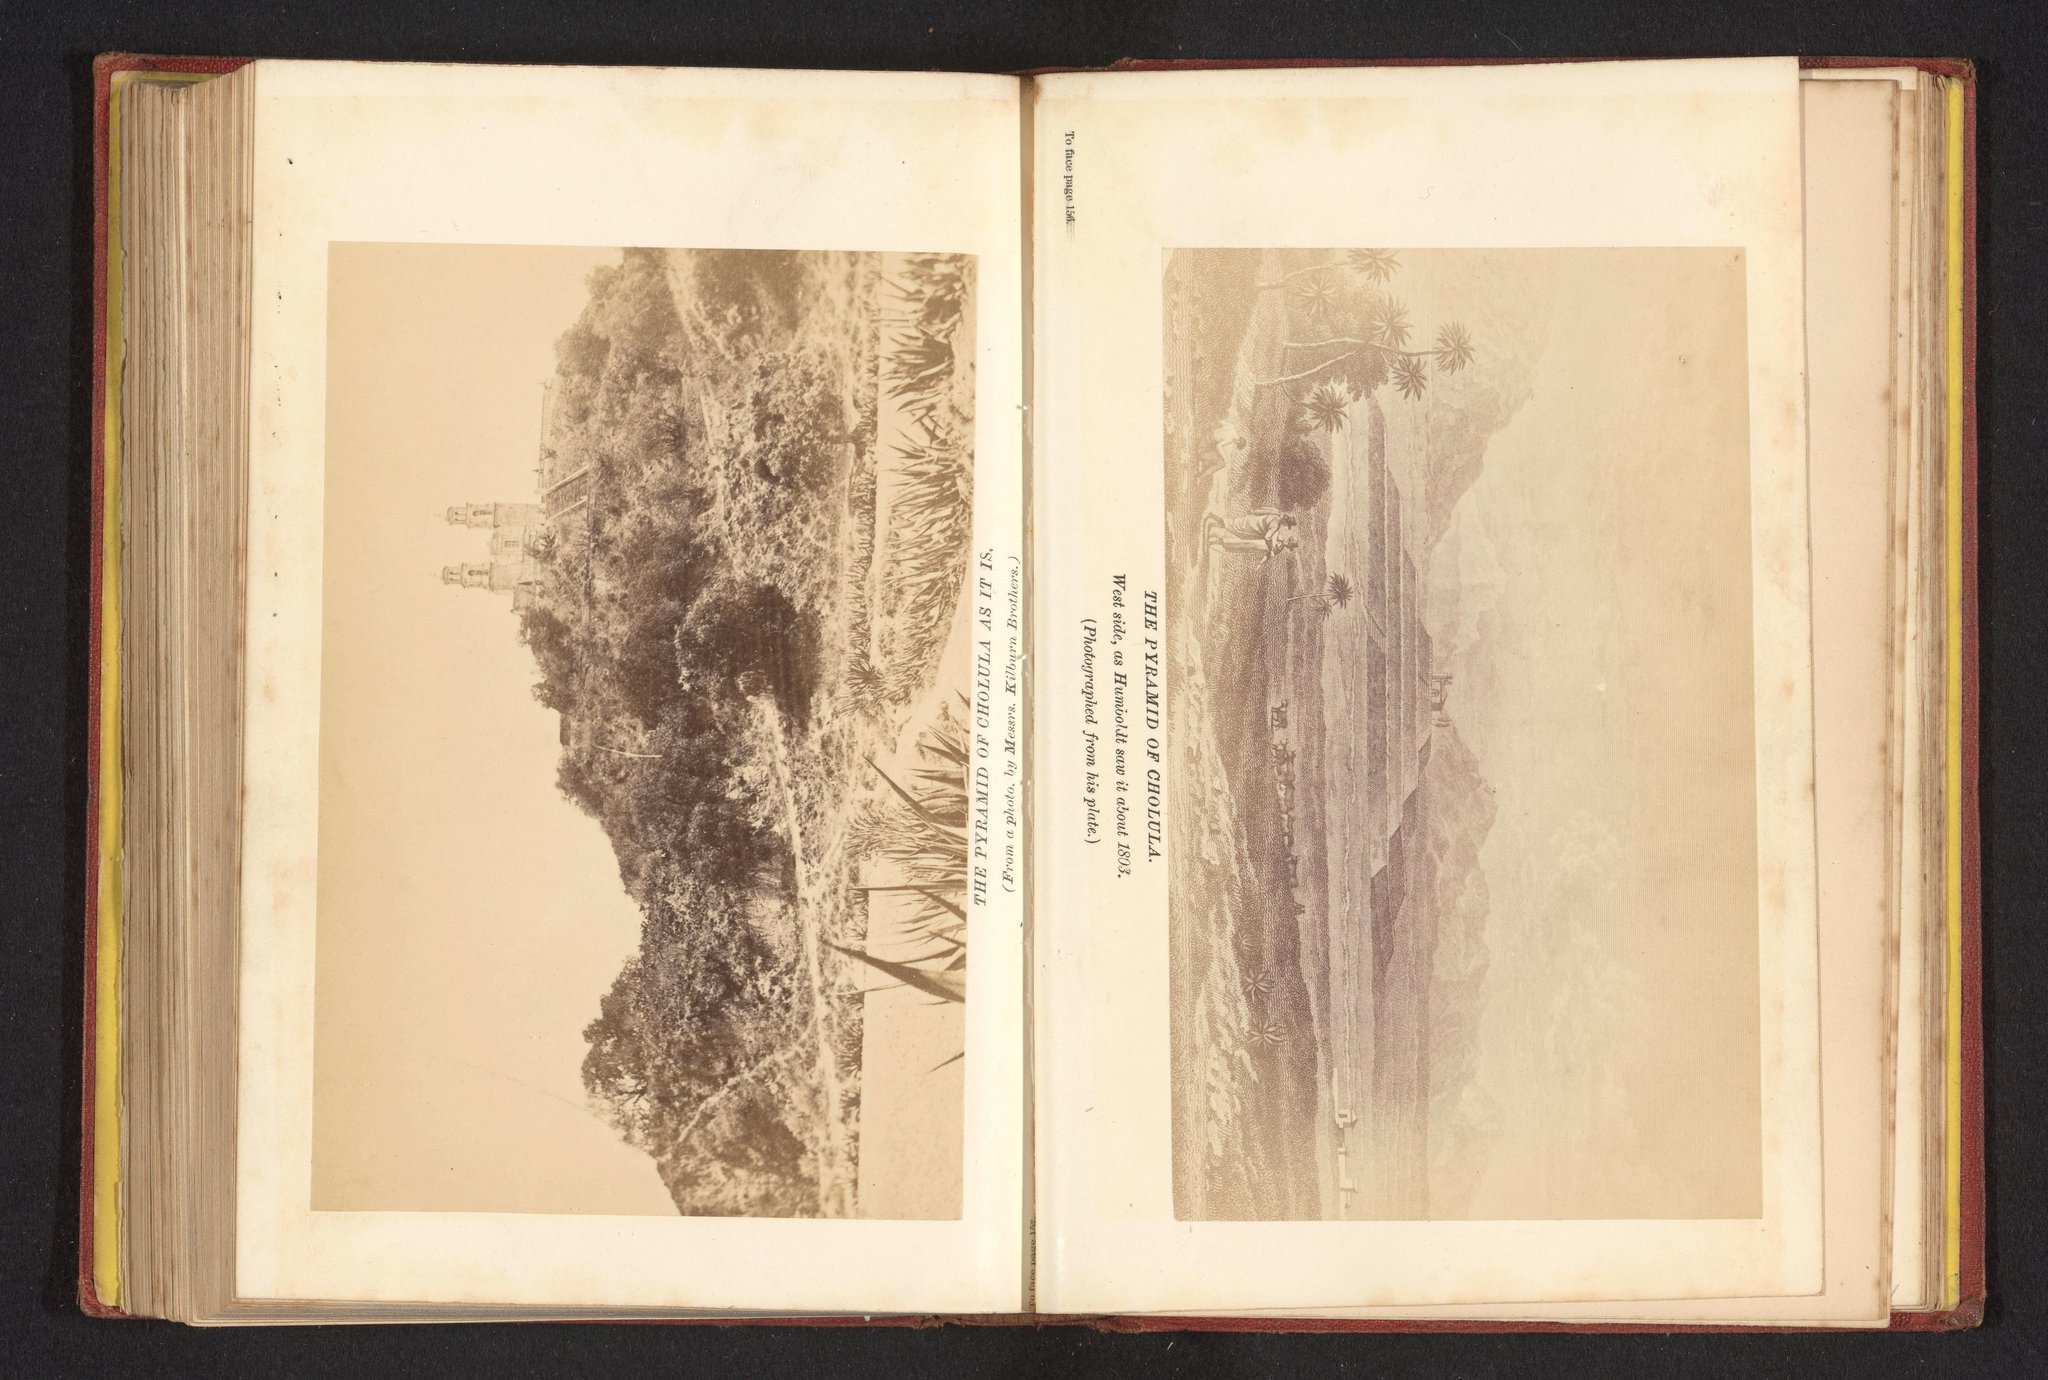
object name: photograph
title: The pyramid of Cholula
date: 1870-1880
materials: photographic support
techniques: albumen print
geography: mexico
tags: quadrangular pyramid, church (exterior)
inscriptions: inscription: ‘West side, as Humboldt saw it about 1803.’